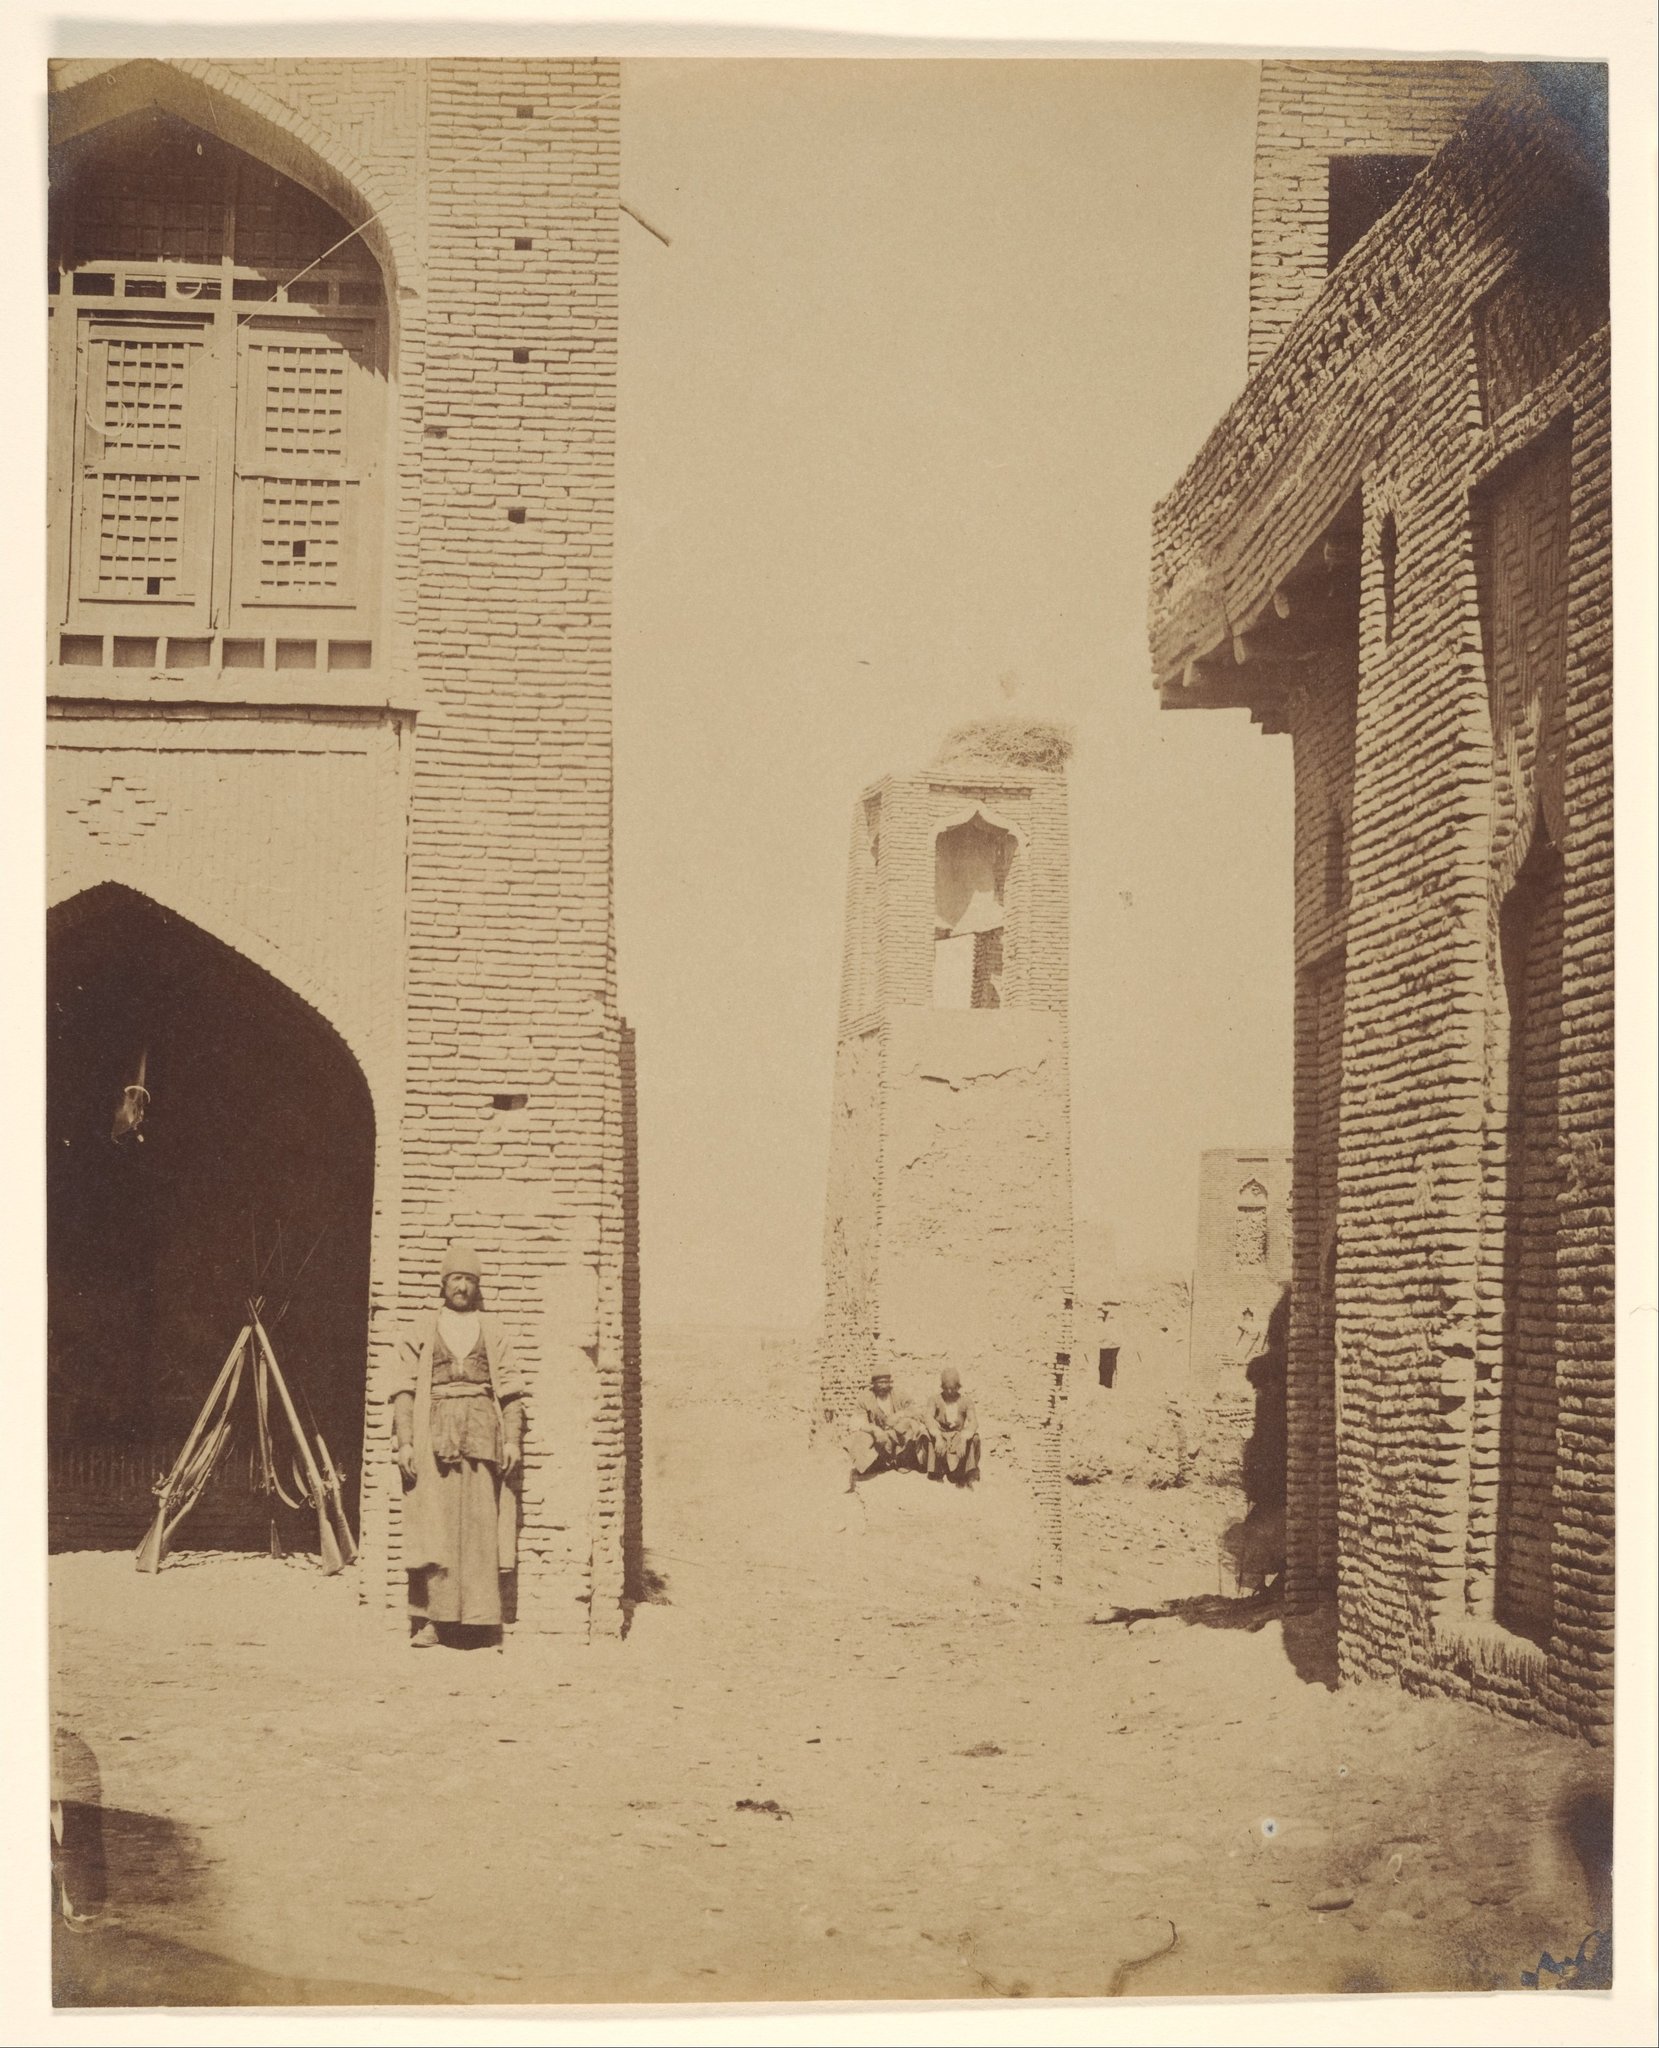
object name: photograph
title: [Ruins, Dizfoul]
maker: luigi pesce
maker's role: artist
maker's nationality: italian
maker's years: 1818-1891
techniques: albumen silver print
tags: ruins